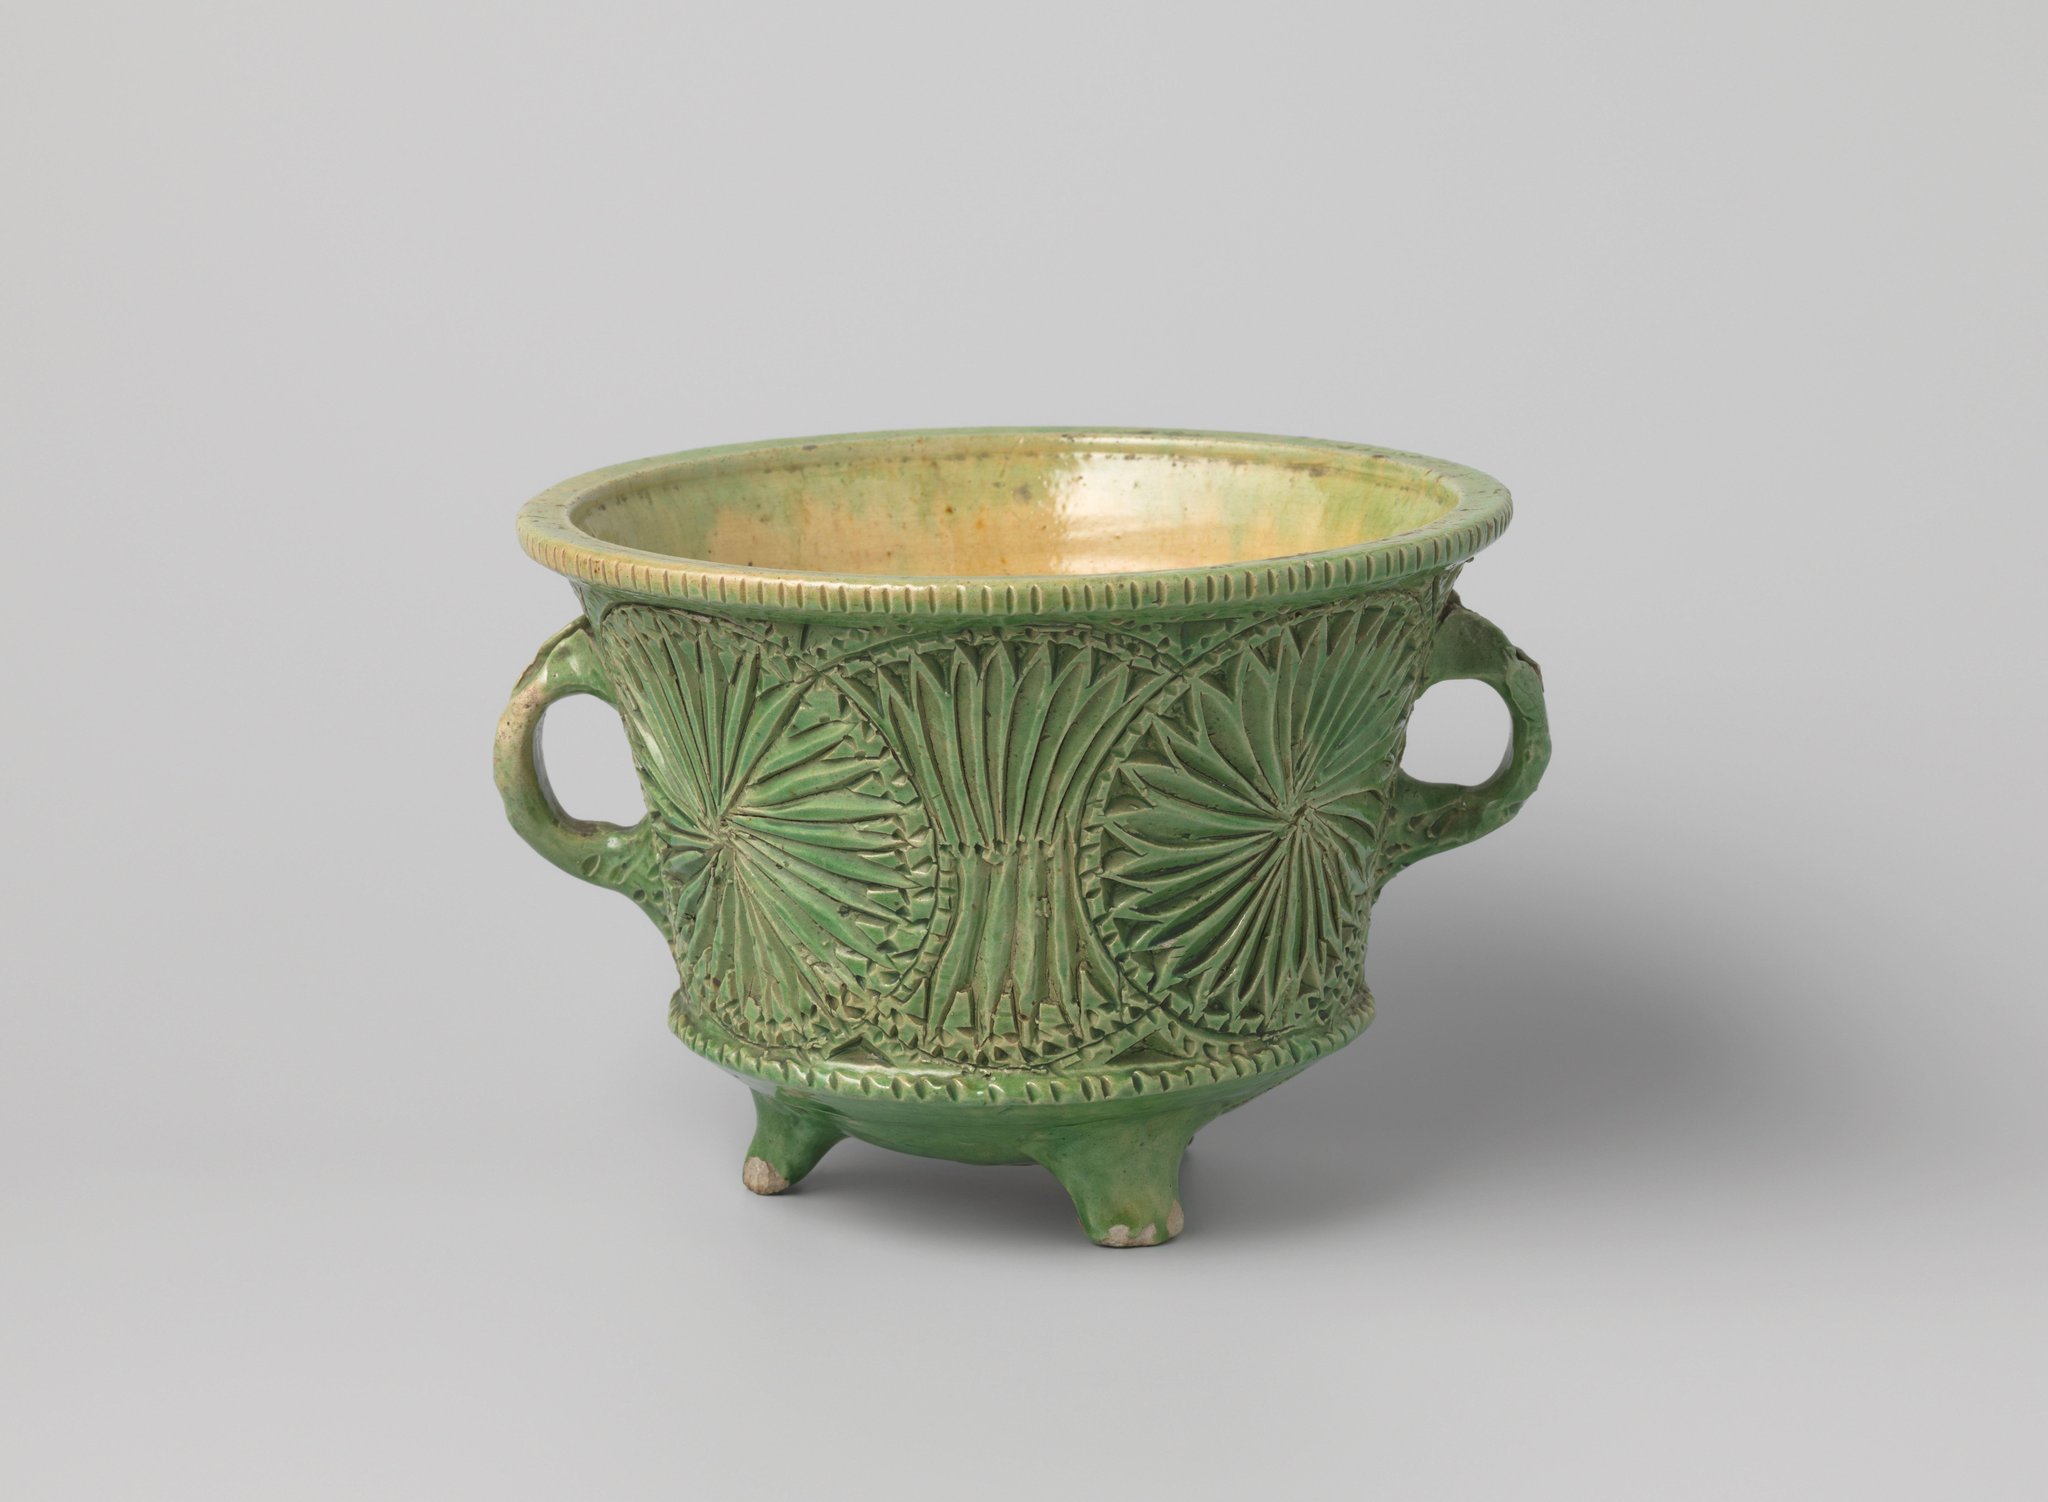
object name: pot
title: Pot van aardewerk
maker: Anonymous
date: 1804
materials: earthenware, glaze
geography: north holland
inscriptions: date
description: Gedrukt bekervormige pot van loodglazuuraardewerk. De pot staat op drie poten en heeft twee oren. De buitenwand is gedecoreerd met grote ingedrukte rozetten. De buitenzijde is groen verglaasd en de binnenzijde geel verglaasd. De pot is aan de onderzijde gedateerd: ANNO 1804.